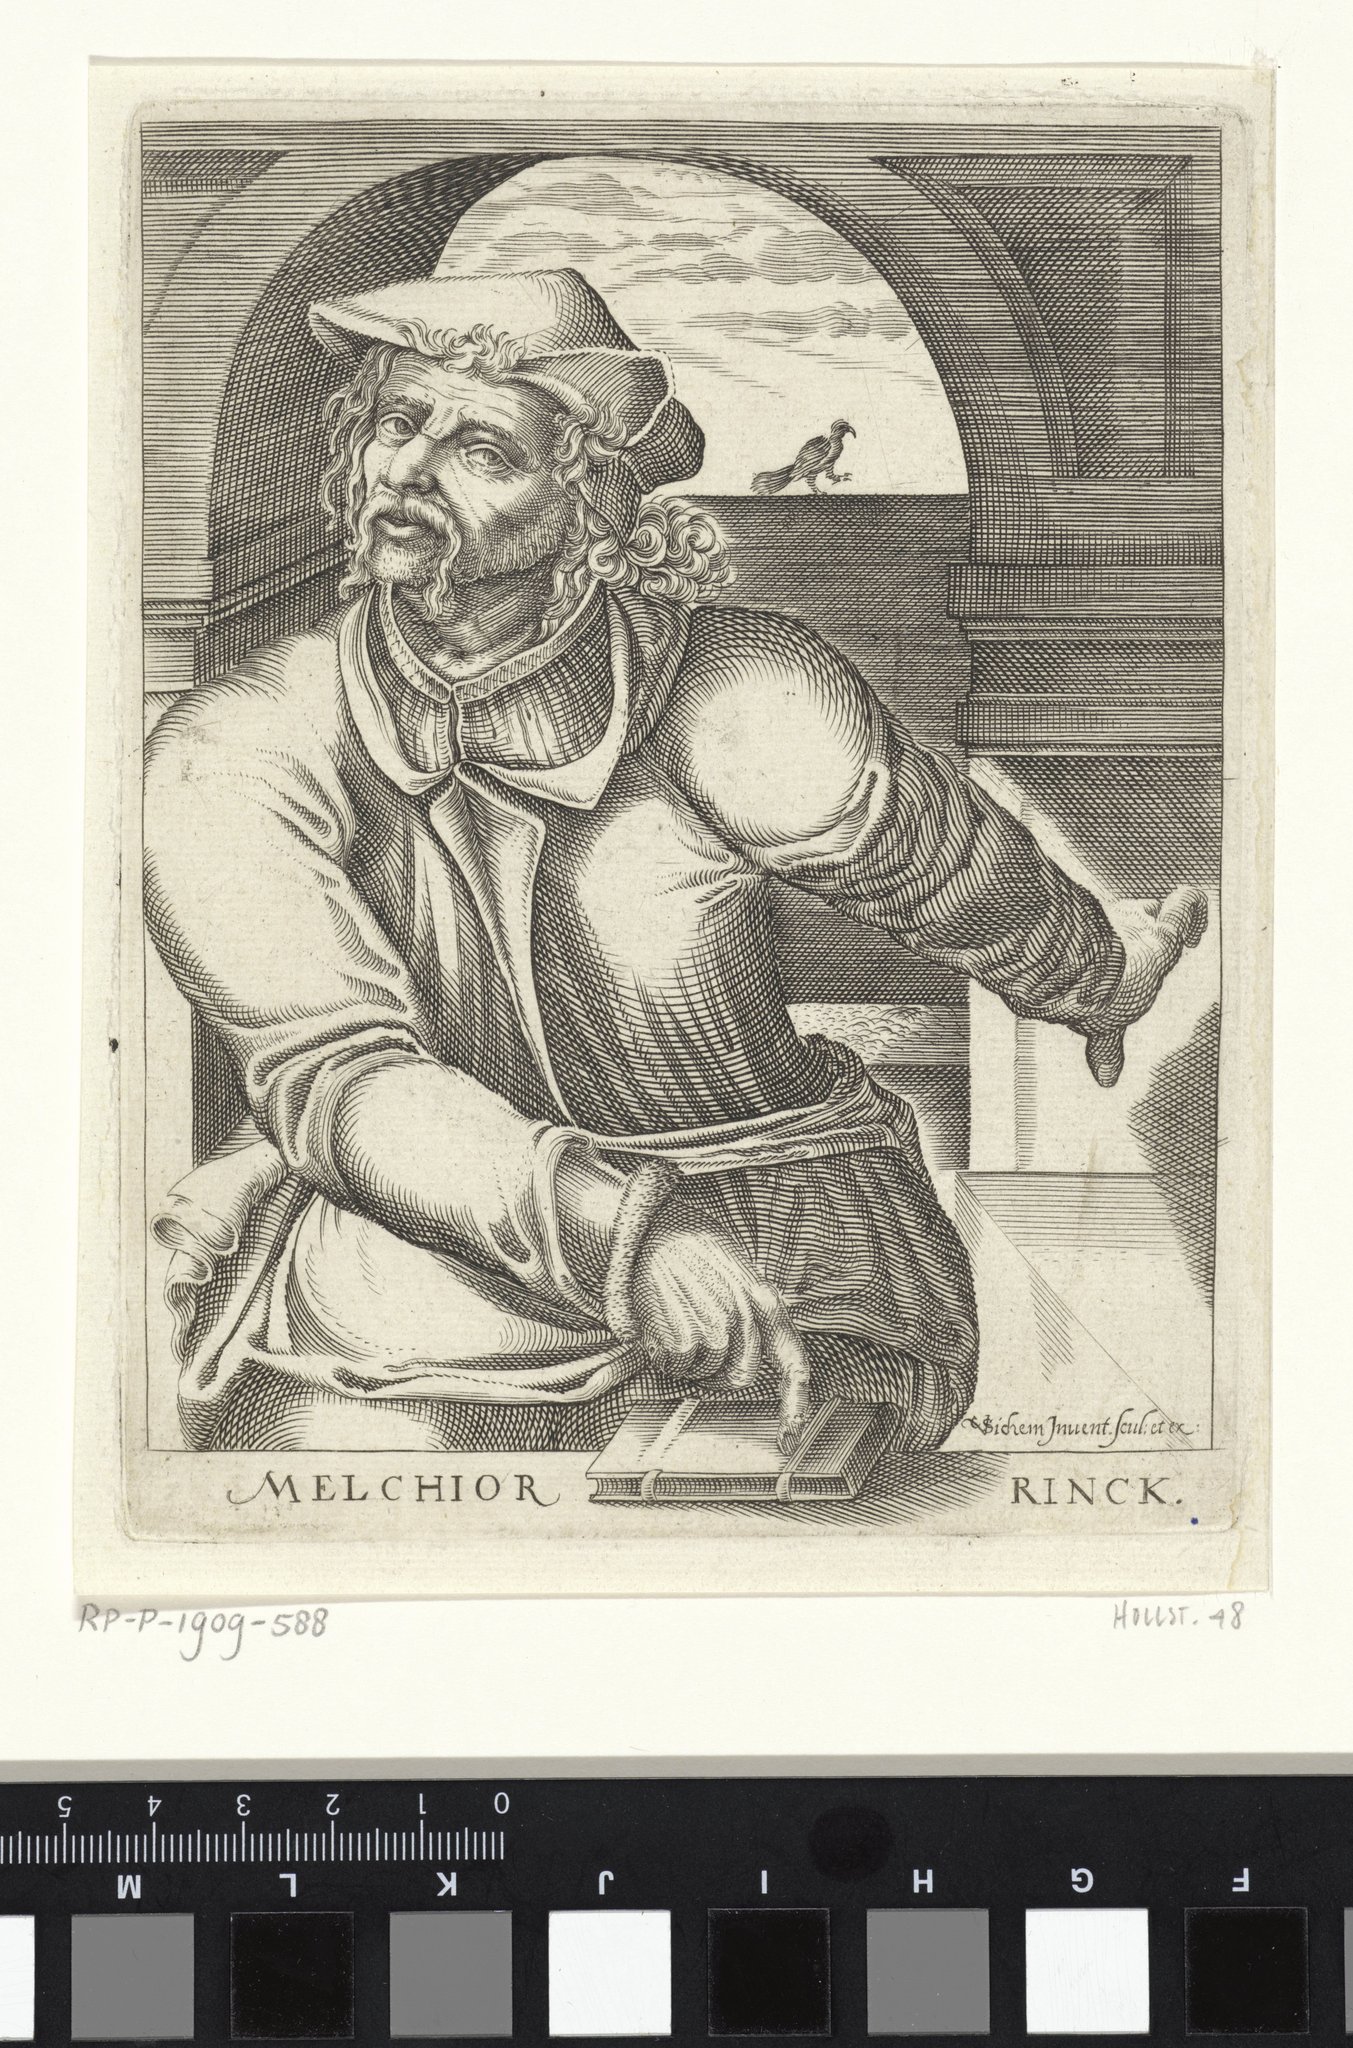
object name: print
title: Portret van Melchior Rinck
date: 1677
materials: paper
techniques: engraving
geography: middelburg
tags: historical persons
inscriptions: collector's mark: Lugt 2228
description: Oorspronkelijk gemaakt voor: 'Historische beschrijvinge ende affbeeldinge der voorneemste hooft ketteren', Amsterdam, C. van Sichem, 1608. Deze prent komt in deze staat voor in: C. van Sichem, 'Het tooneel der hooft-ketteren, bestaande in verscheyde afbeeltsels...', Middelburg, Wilhelmus Goeree, 1677.